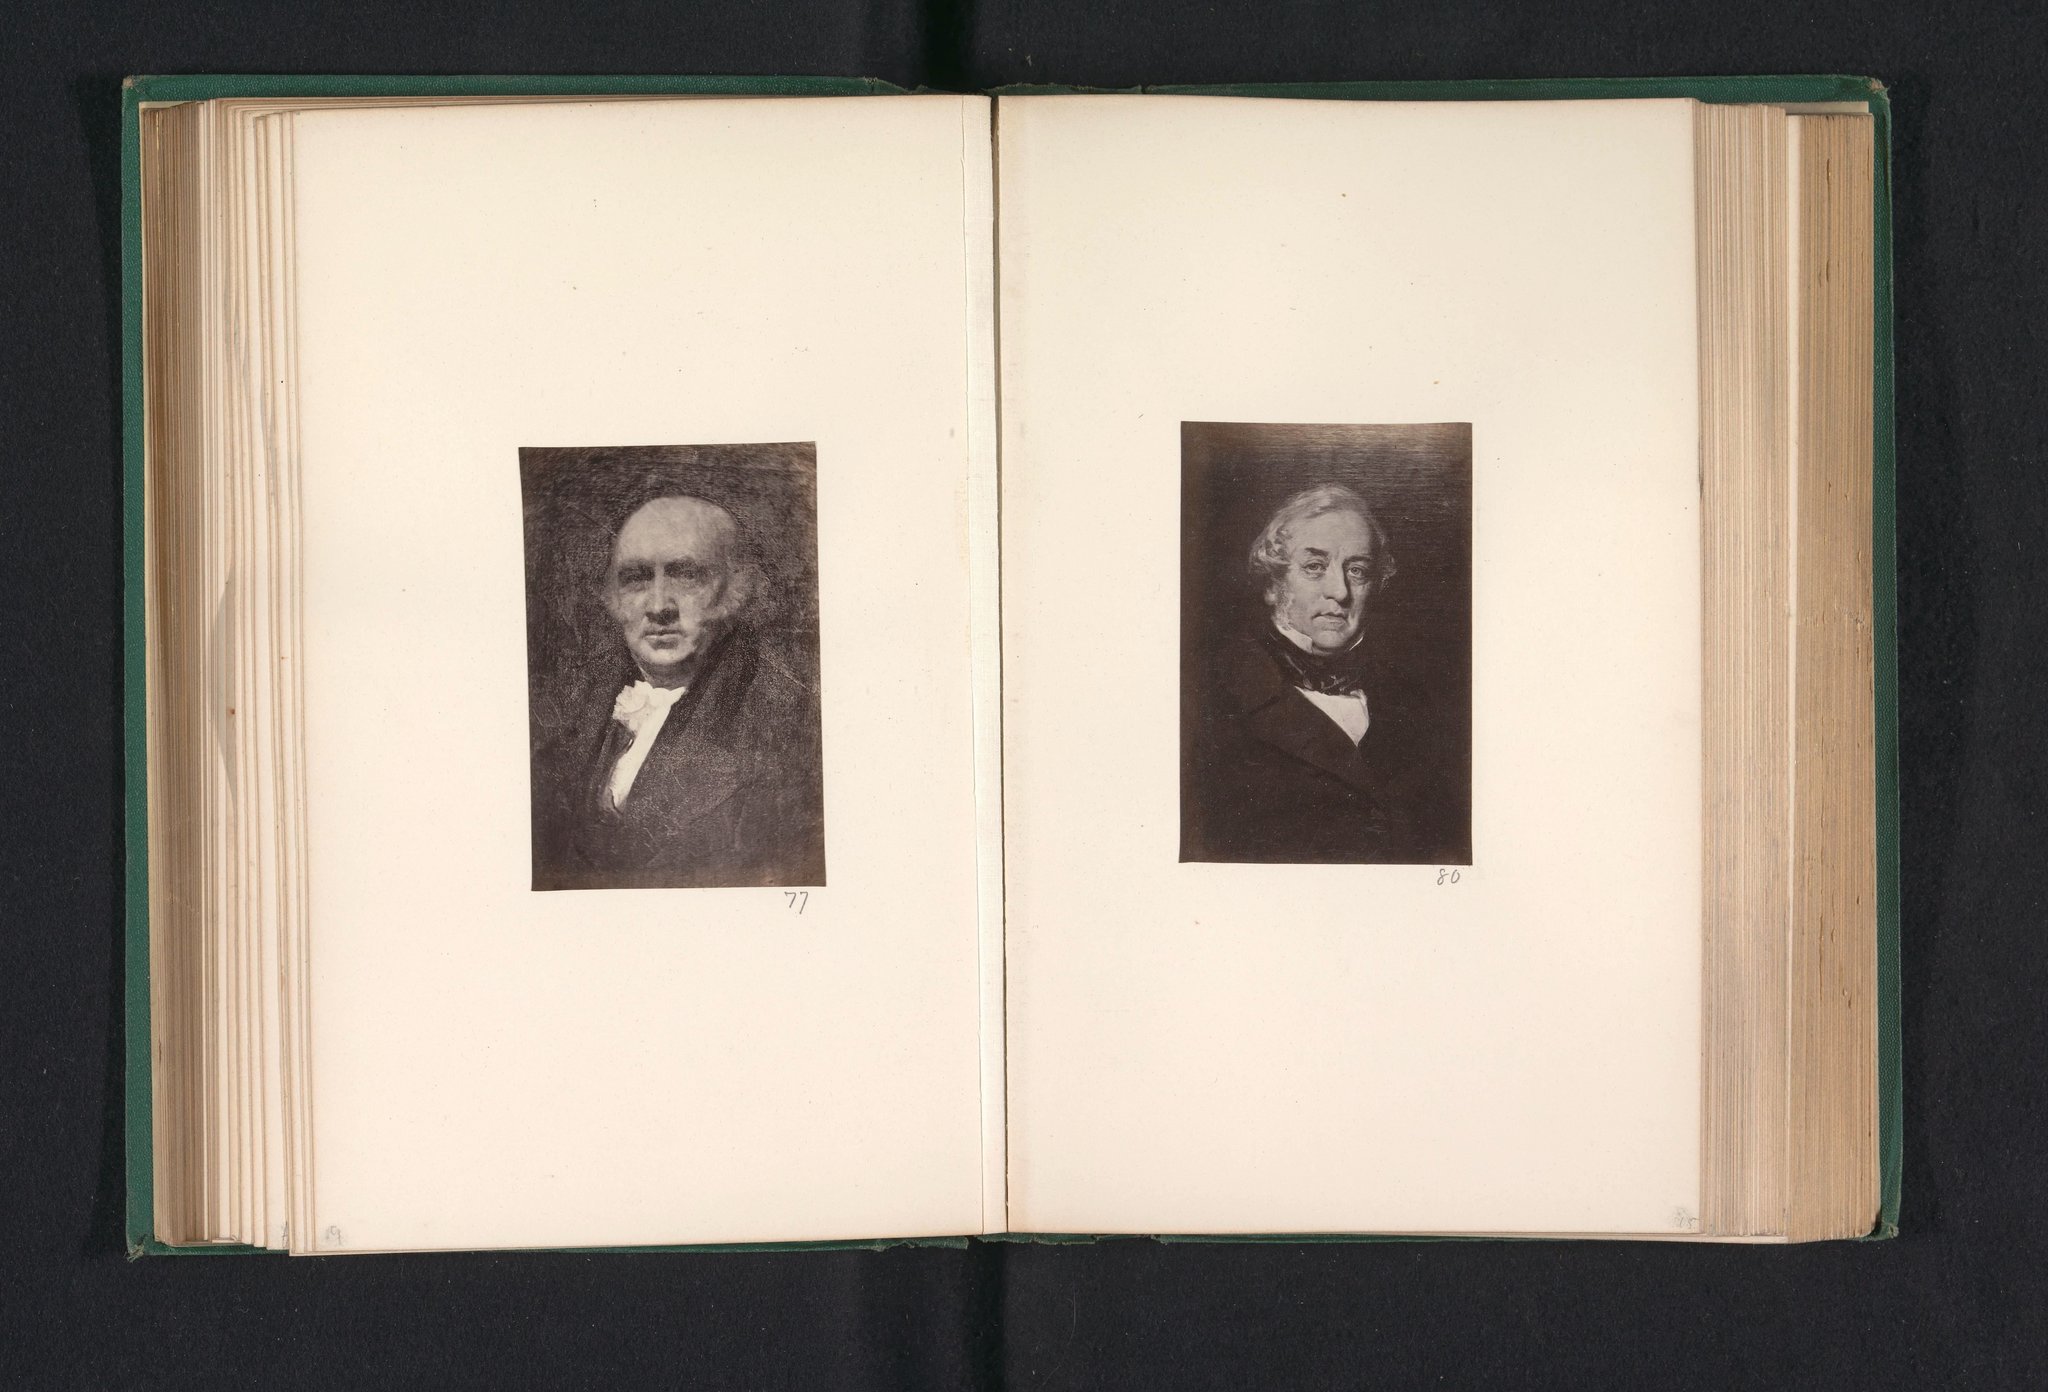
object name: reproduction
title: Fotoreproductie van een schilderij, voorstellende een portret van Robert Cleghorn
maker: thomas annan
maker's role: fotograaf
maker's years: 1829-1887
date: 1863-1868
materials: photographic support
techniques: albumen print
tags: historical persons (portraits and scenes from the life) (+ (full) bust portrait)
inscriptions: number: ‘77’